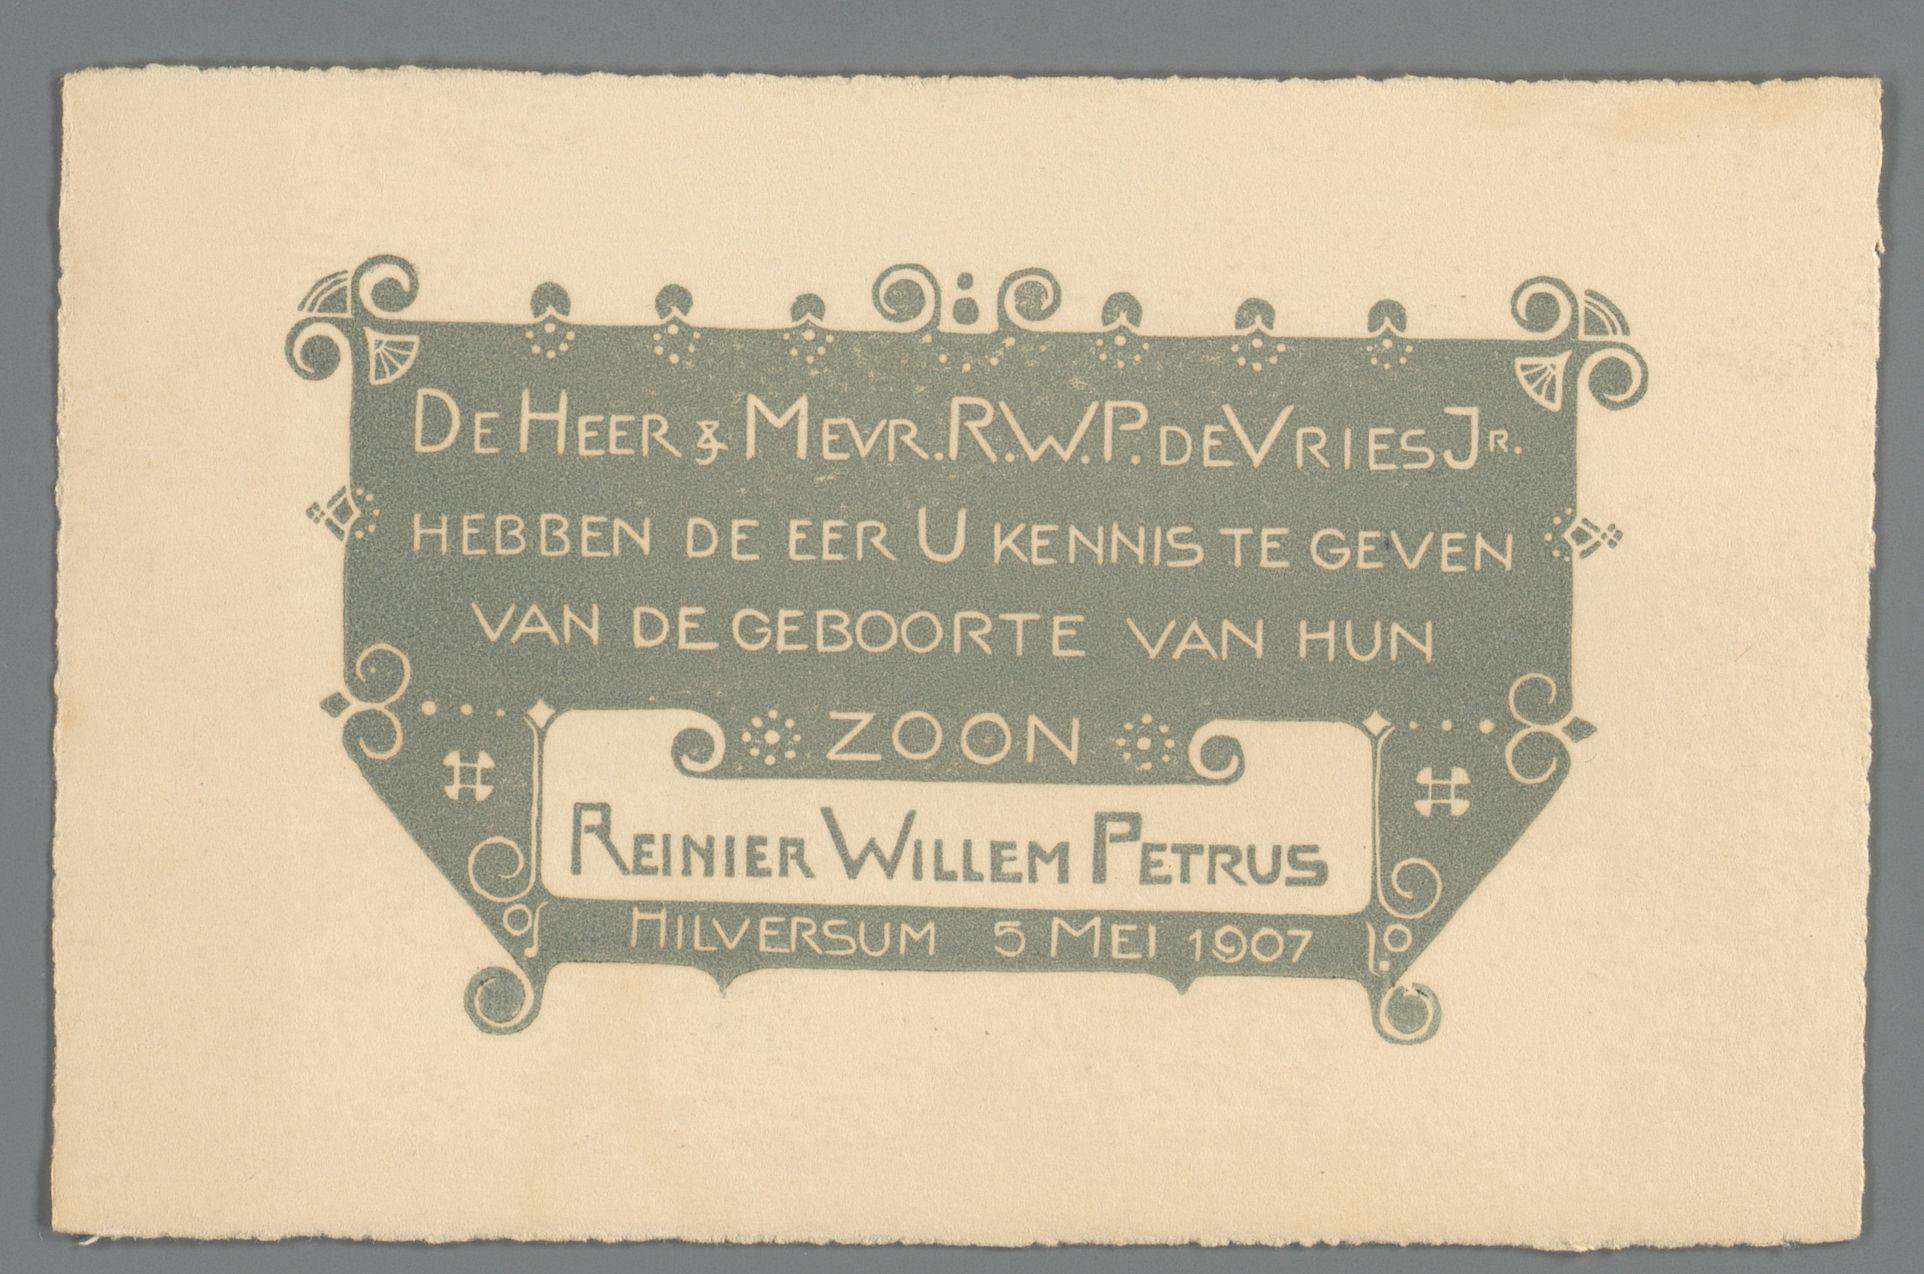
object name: birth announcement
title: Geboortekaart voor Reinier Willem Petrus de Vries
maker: reinier willem petrus de vries (1874-1953)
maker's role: draughtsman, print maker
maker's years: 1874-1953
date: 1907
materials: paper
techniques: lithograph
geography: hilversum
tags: amsterdam, print maker, draughtsman, reinier willem petrus de vries (1874-1953), engineer, reinier willem petrus de vries (1907-?), announcement of birth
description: In een decoratieve rand de tekst: 'De heer & mevr. R.W.P. de Vries Jr. hebben de eer U kennis te geven van de geboorte van hun zoon Reinier Willem Petrus. Hilversum 5 mei 1907'.